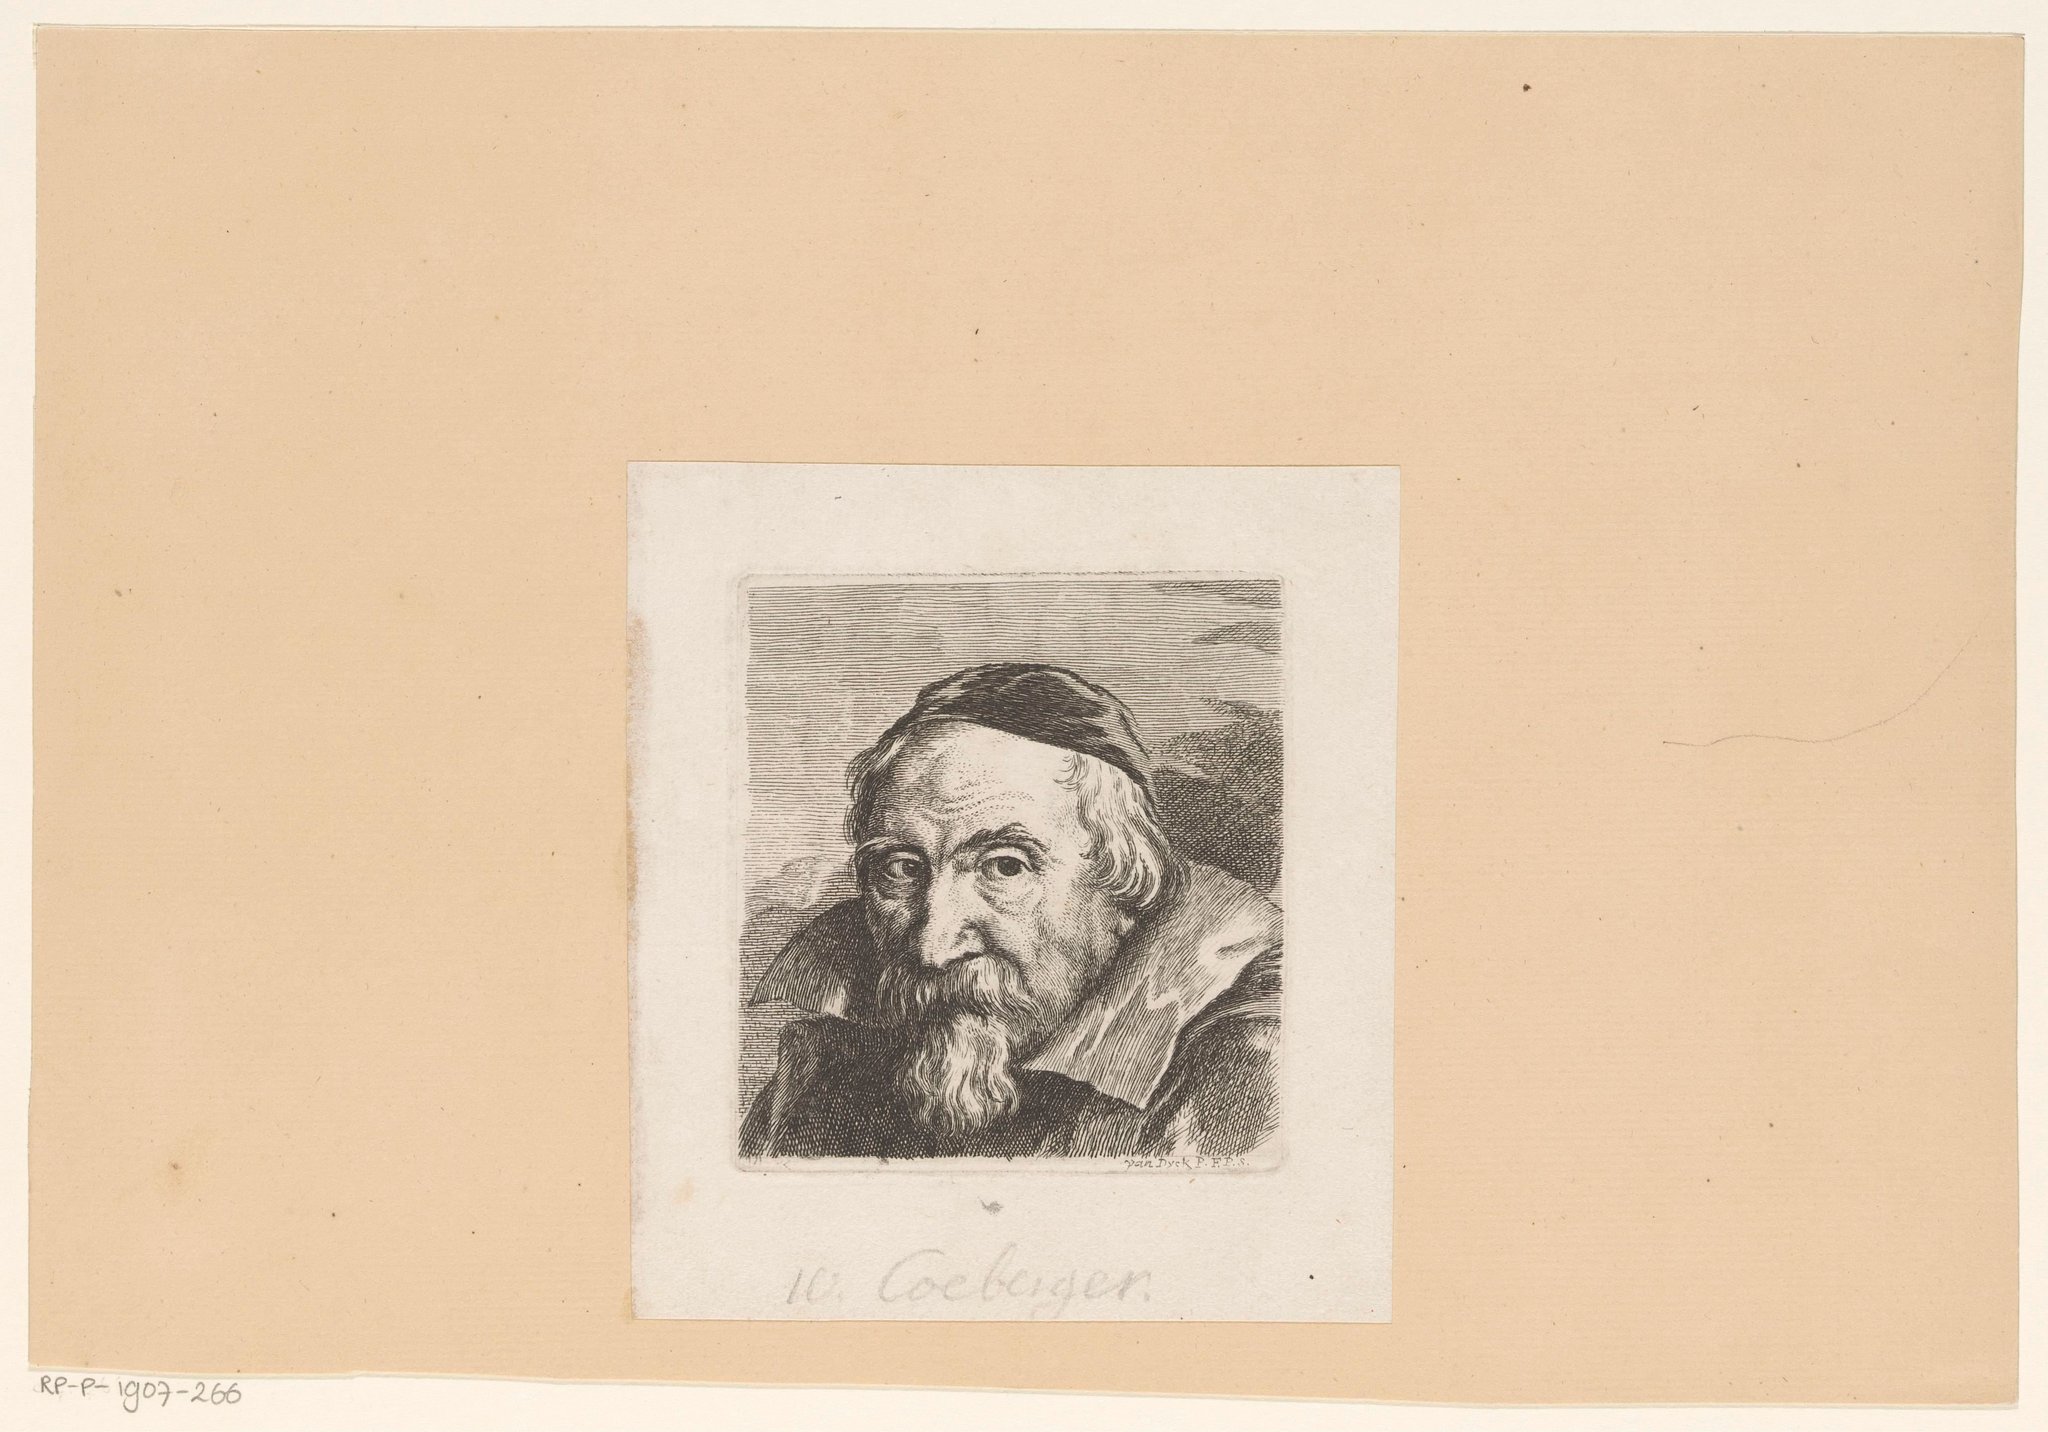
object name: print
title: Portret van Wenzel Coebergher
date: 1710-1783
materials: paper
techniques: etching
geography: italy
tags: antwerp, painter, draughtsman, wenzel coebergher, historical persons, portrait, self-portrait of artist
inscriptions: collector's mark: Lugt 2228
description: Deze prent maakt deel uit van een serie van 13 prenten.